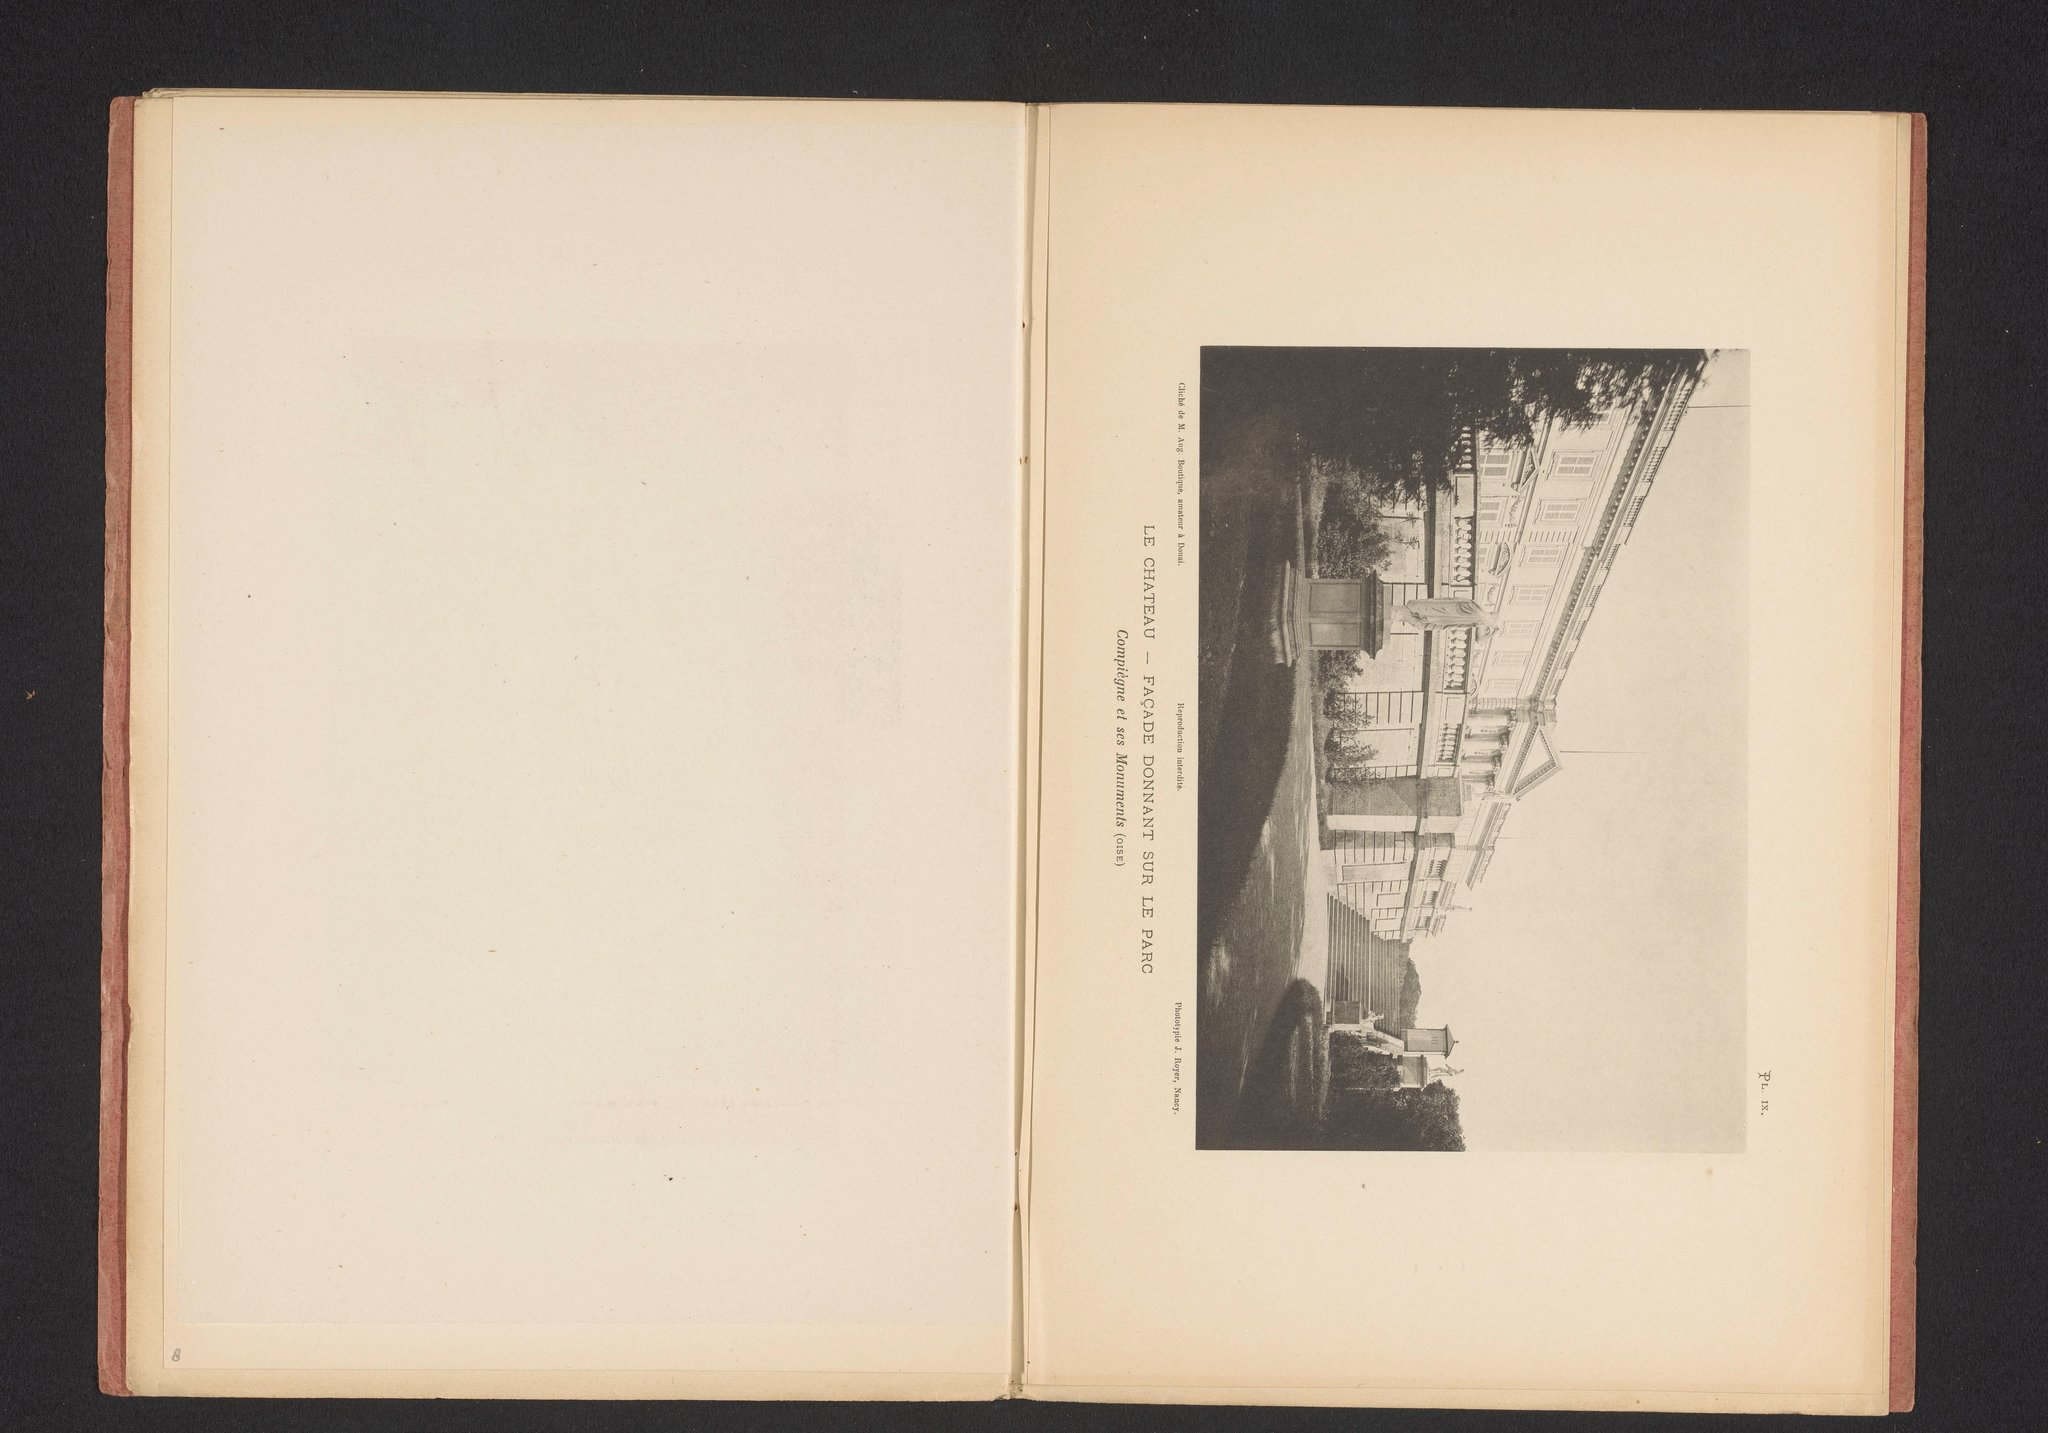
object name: photomechanical print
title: Le Chateau - Façade Donnant sur le Parc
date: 1890-1895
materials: paper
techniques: photograph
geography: compiègne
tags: park, castle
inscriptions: number: ‘Pl. IX.’, inscription: ‘Reproduction interdite.’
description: Prent op derde ongenummerde pagina na pagina 6.